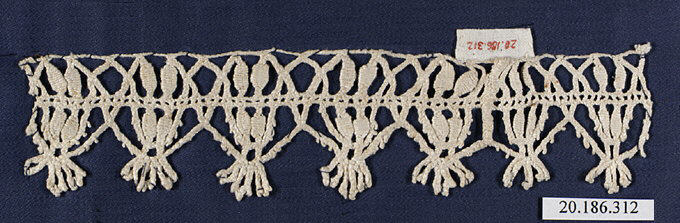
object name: edging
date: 1501-1600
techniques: lace